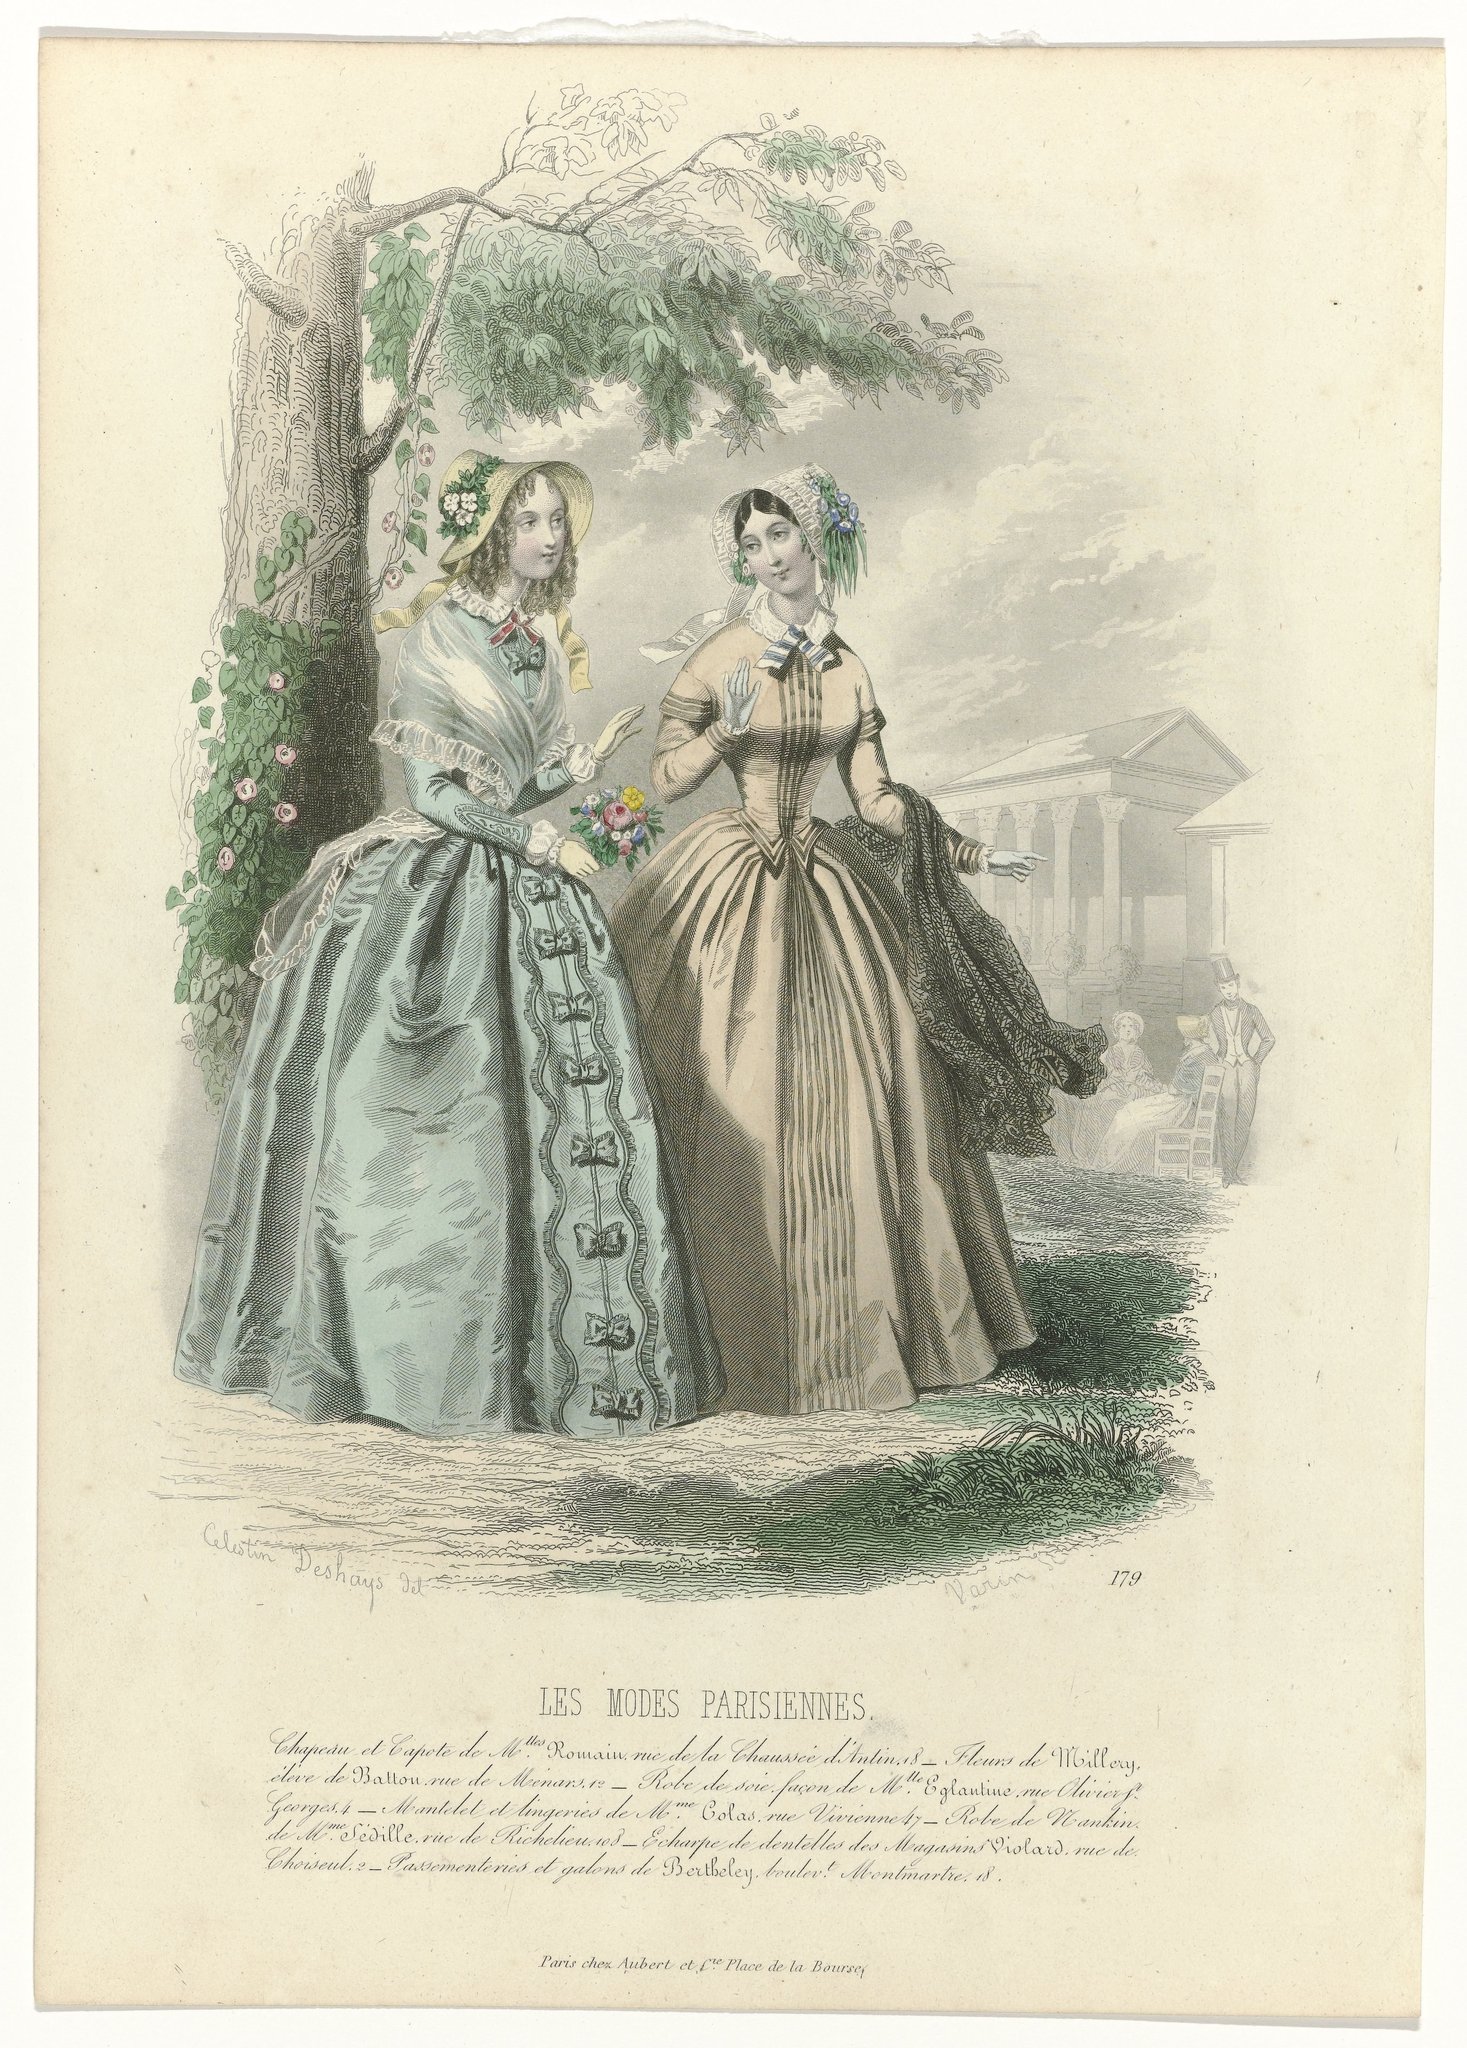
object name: fashion print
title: Les Modes Parisiennes, 1846, No. 179 : Chapeau et Capot (...)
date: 1846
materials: paper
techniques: engraving, hand coloring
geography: paris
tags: cut flowers; nosegay, bunch of flowers, head-gear (capote) (+ women's clothes), clothing for the upper part of the body (shawl) (+ women's clothes), ornamental parts of clothing (+ women's clothes), clothing for the upper part of the body (shawl) (+ lace used for clothes), clothing for the upper part of the body (mantelet) (+ women's clothes), fashion plates, head-gear: hat (+ women's clothes), gloves, mittens, etc. (+ women's clothes), dress, gown (+ women's clothes), neck-gear ~ clothing (+ women's clothes)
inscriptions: caption: ‘Chapeau et Capote de M.lles Romain, rue de la Chaussée d'Antin, 18_ Fleurs de Millery, élève de Batton, rue de Ménars, 12_ Robe de soie, façon de M.lle Eglantine, rue Olivier S"t Georges.4_ Mantelet et lingeries de M.me Colas, rue Vivienne 47_ Robe de Nankin de M.me Sédille, rue de Richelieu, 108_ Echarpe de dentelles des Magasins Violard, rue de Choiseul, 2_ Passementeries et galons de Bertheley, boulev.t Montmartre, 18.’, title: ‘Les Modes Parisiennes.’, address: ‘Paris chez Aubert et C.ie Place de la Bourse.’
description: Twee vrouwen bij een boom. In de verte een tuinlandschap met een antieke tempel. Volgens het onderschrift: hoed en 'capote' van Romain. Bloemen van Millery, leerling van Battou. Japon van zijde, uitgevoerd op de manier van Eglantine. Kleine schoudermantel en 'lingeries' van Colas. Japon van 'nankin' van Sédille. Sjaal van kant uit de winkels van Violard. Passementerie en galons van Bertheley. Prent uit het modetijdschrift Les Modes Parisiennes (1843-1885).